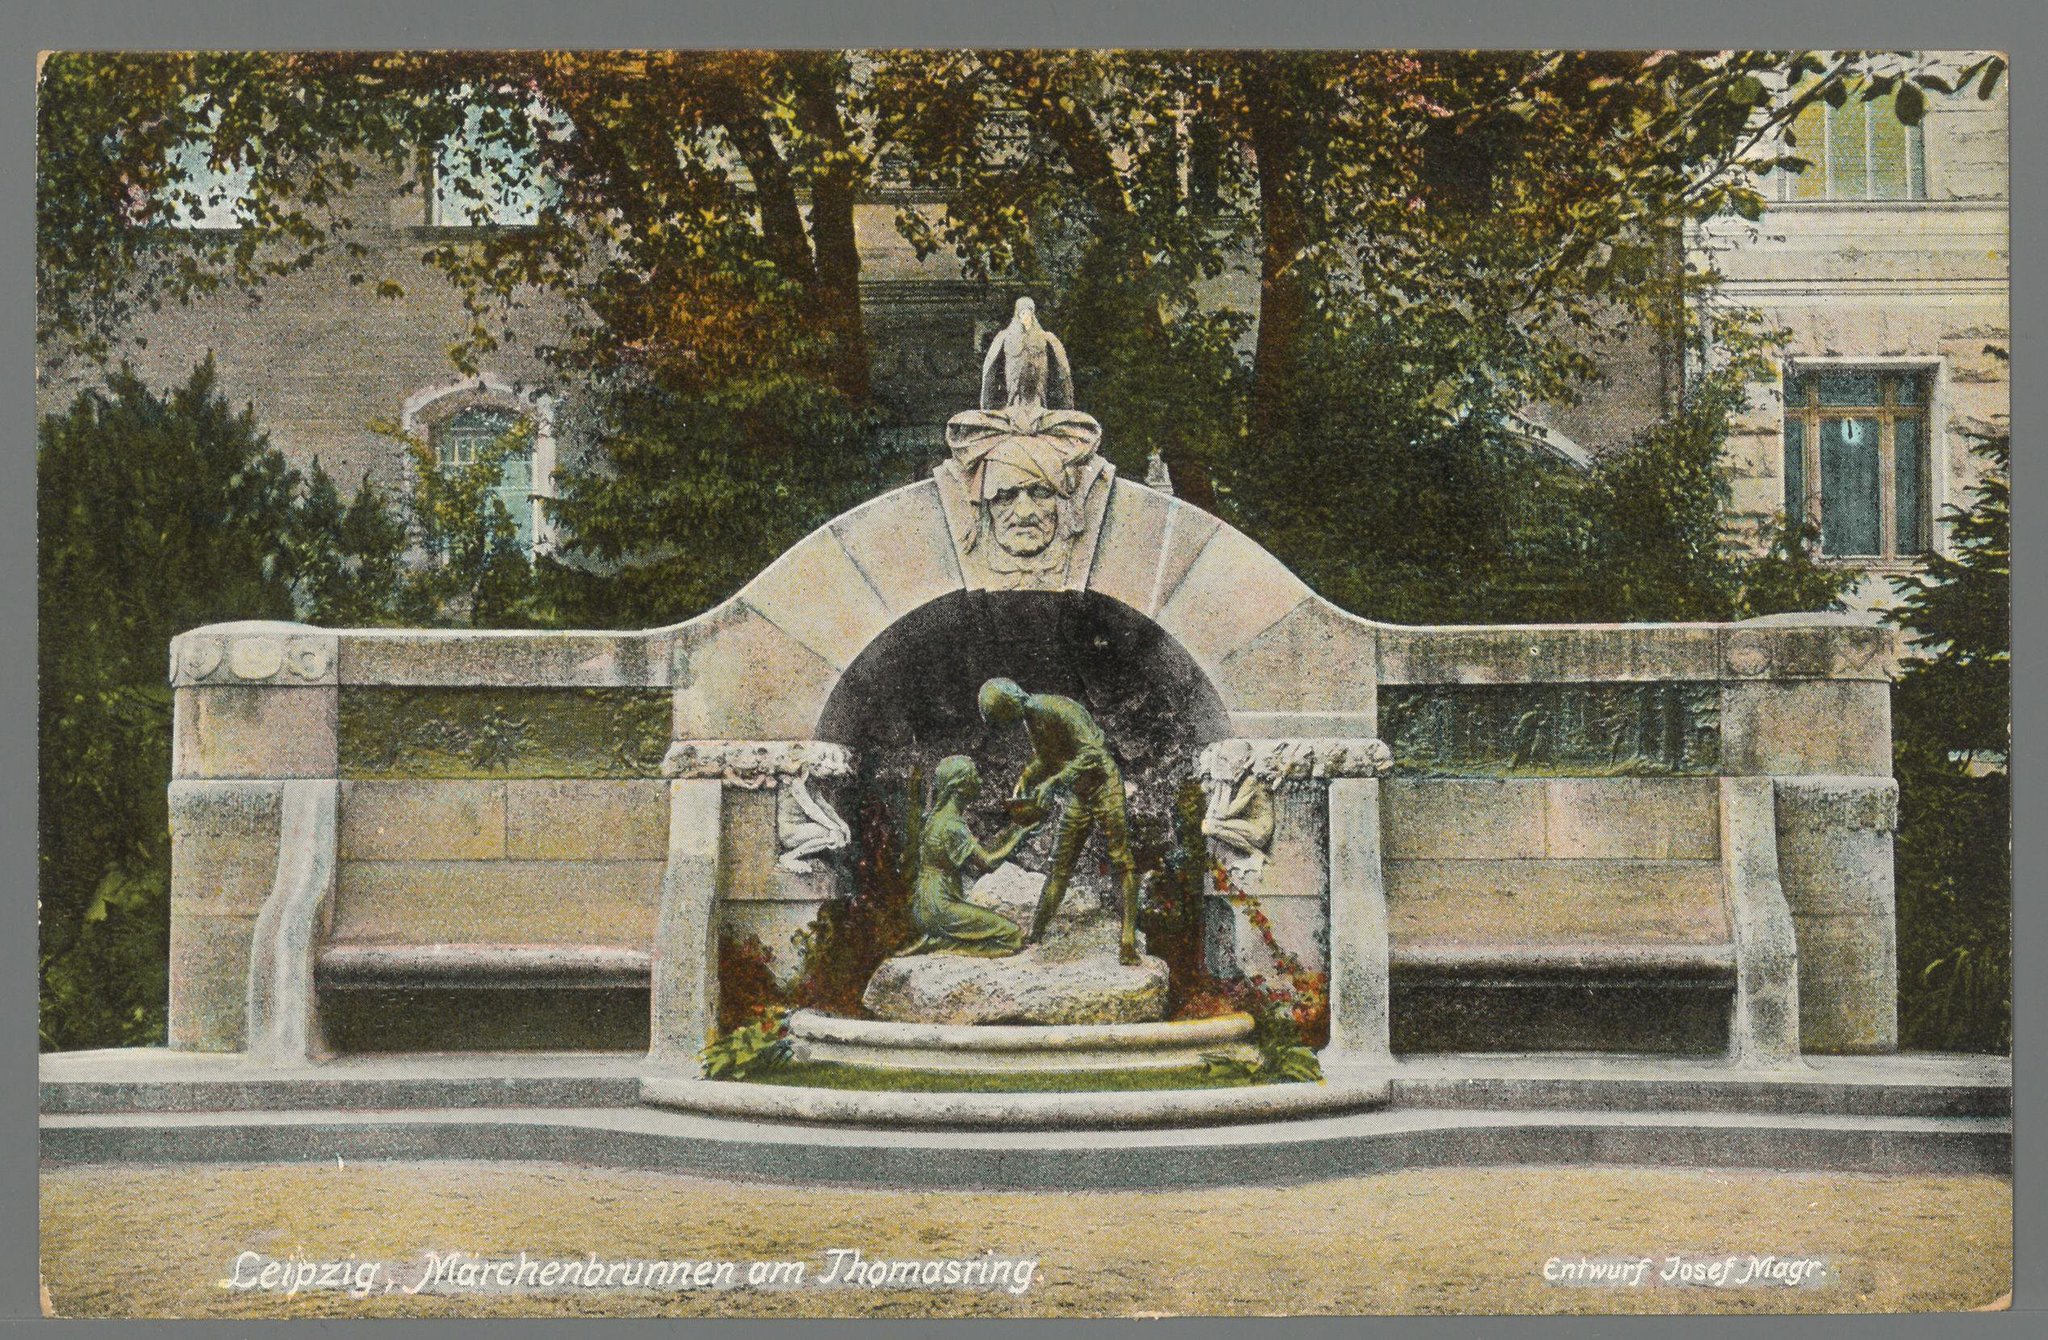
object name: ansichtkaart, prentbriefkaart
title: Leipzig, Märchenbrunnen am Thomasring. Entwurf Josef Magr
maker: Anonymous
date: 1908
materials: cardboard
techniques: lithograph, writing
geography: leipzig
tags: ornamental fountain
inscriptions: date